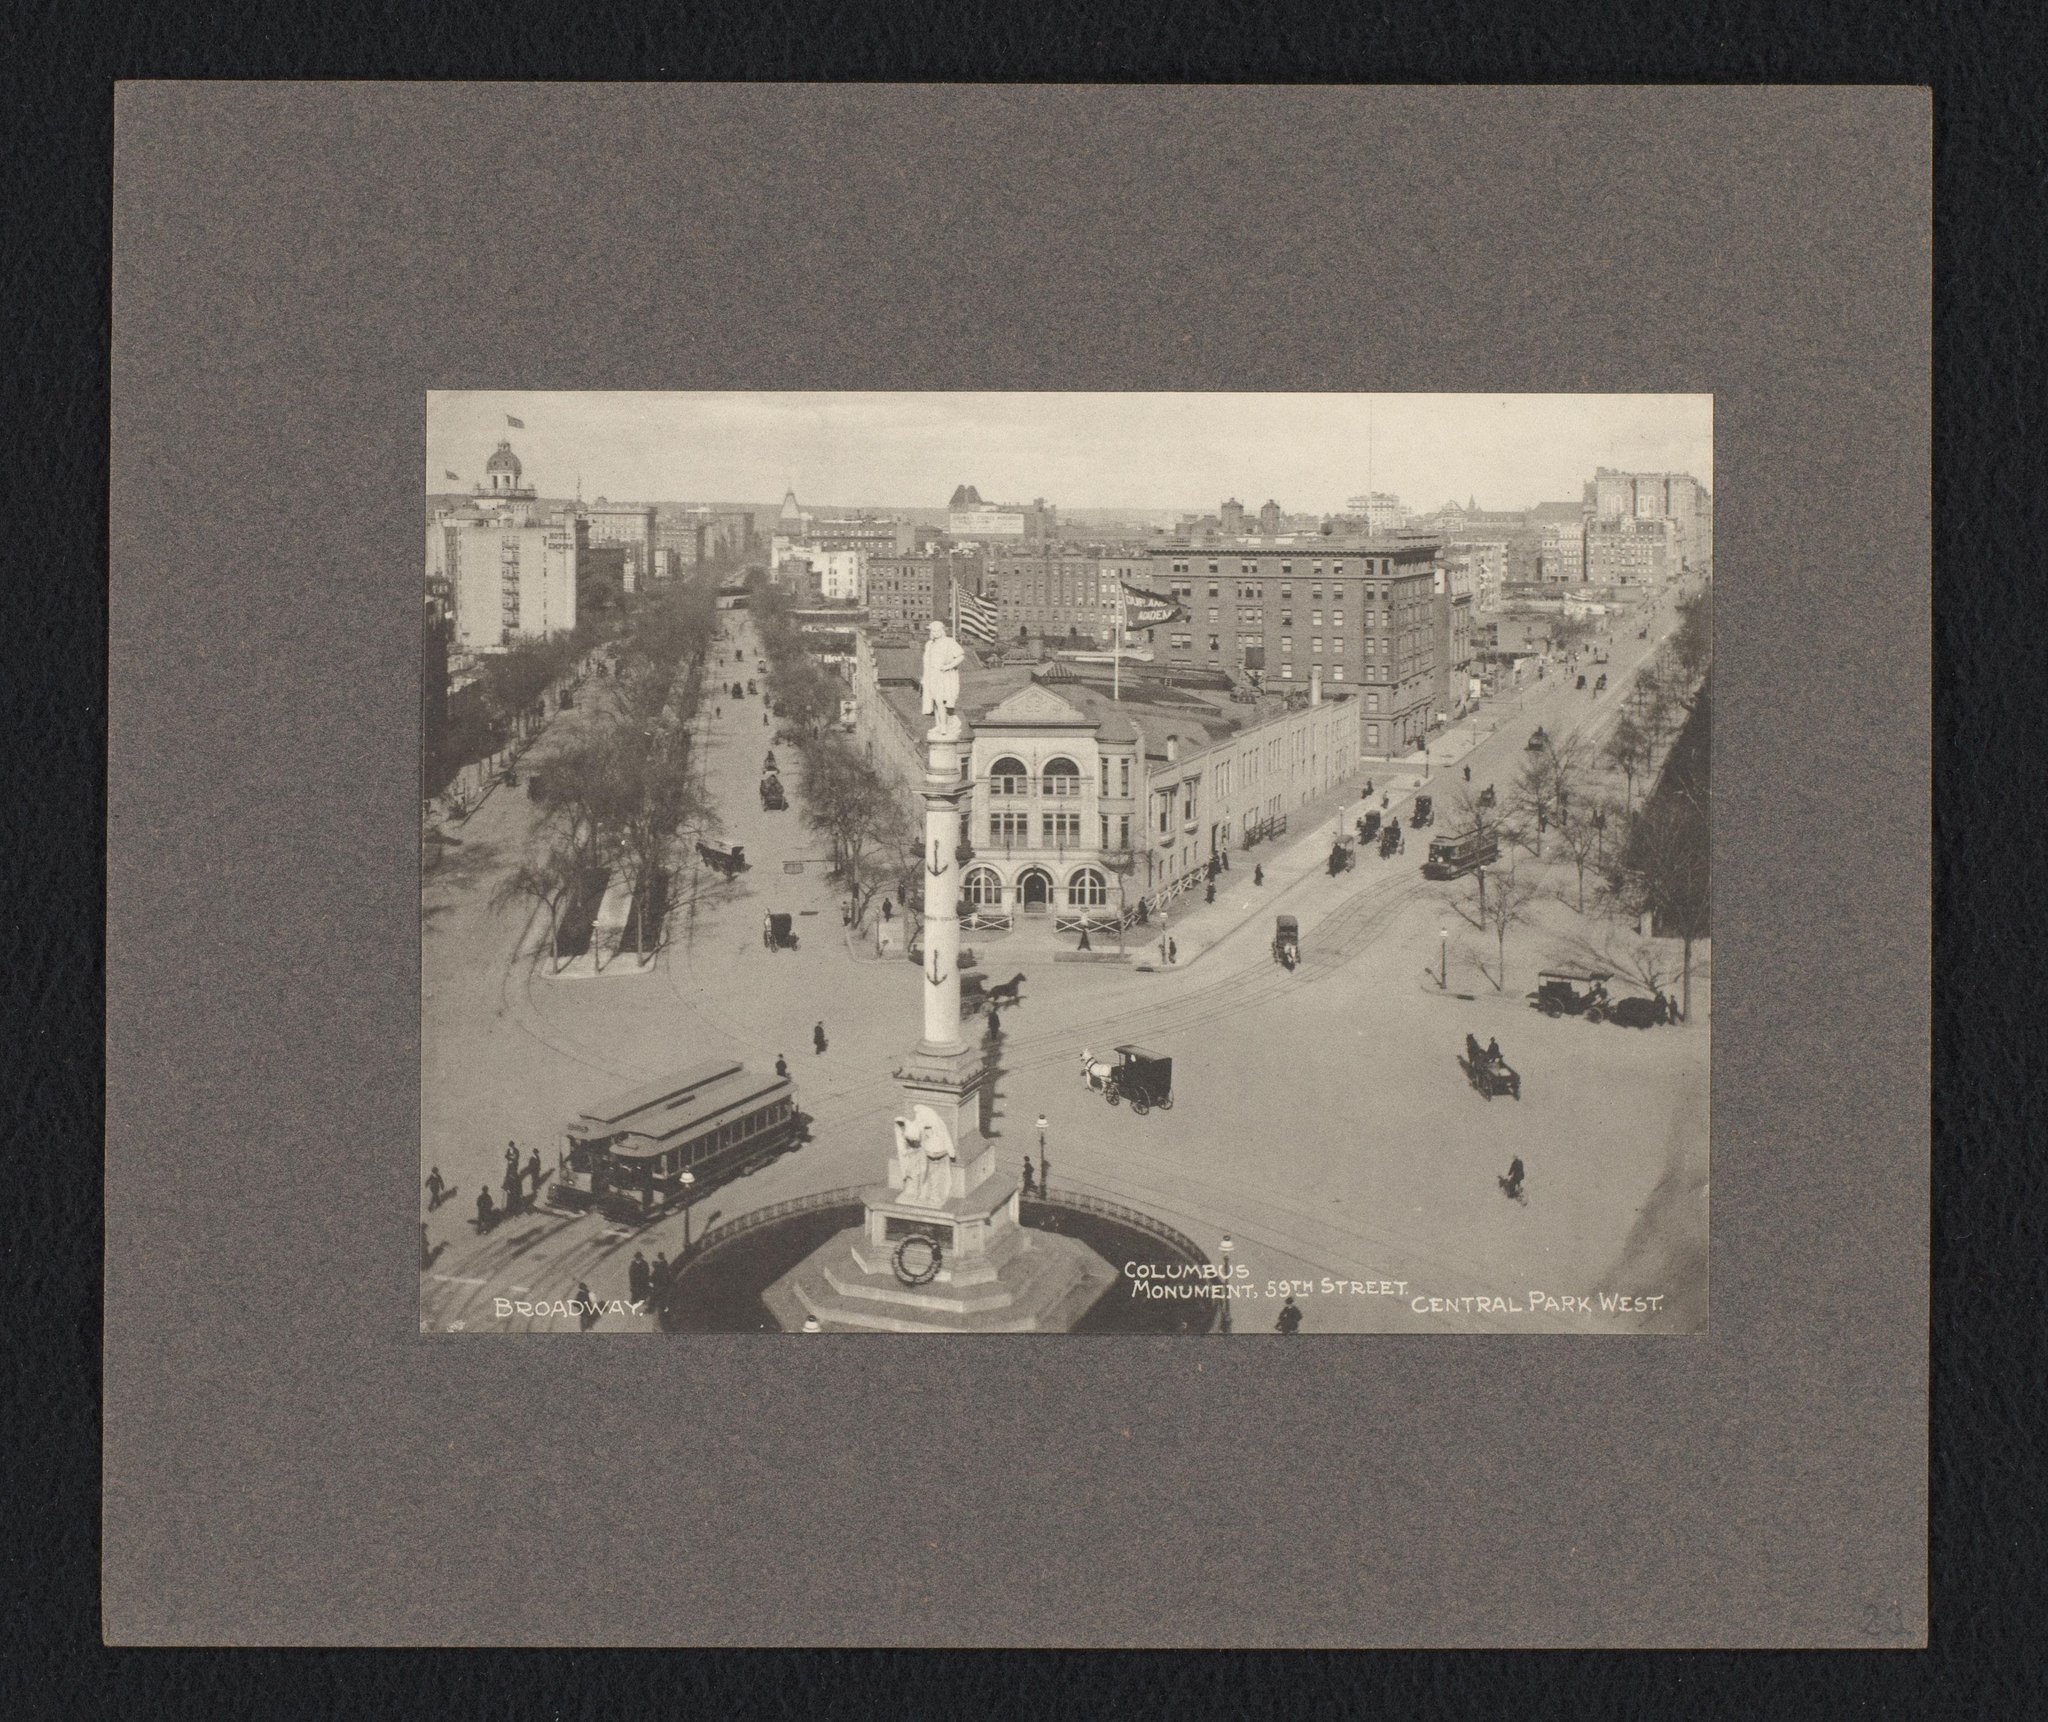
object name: album leaf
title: Gezicht op het Columbus Monument op de kruising van Broadway en 59th Street, New York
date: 1902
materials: paper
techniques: photograph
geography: new york city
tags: city-view in general; 'veduta', monument, statue, avenue, boulevard, promenade, esplanade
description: Deze prent maakt deel uit van een album.